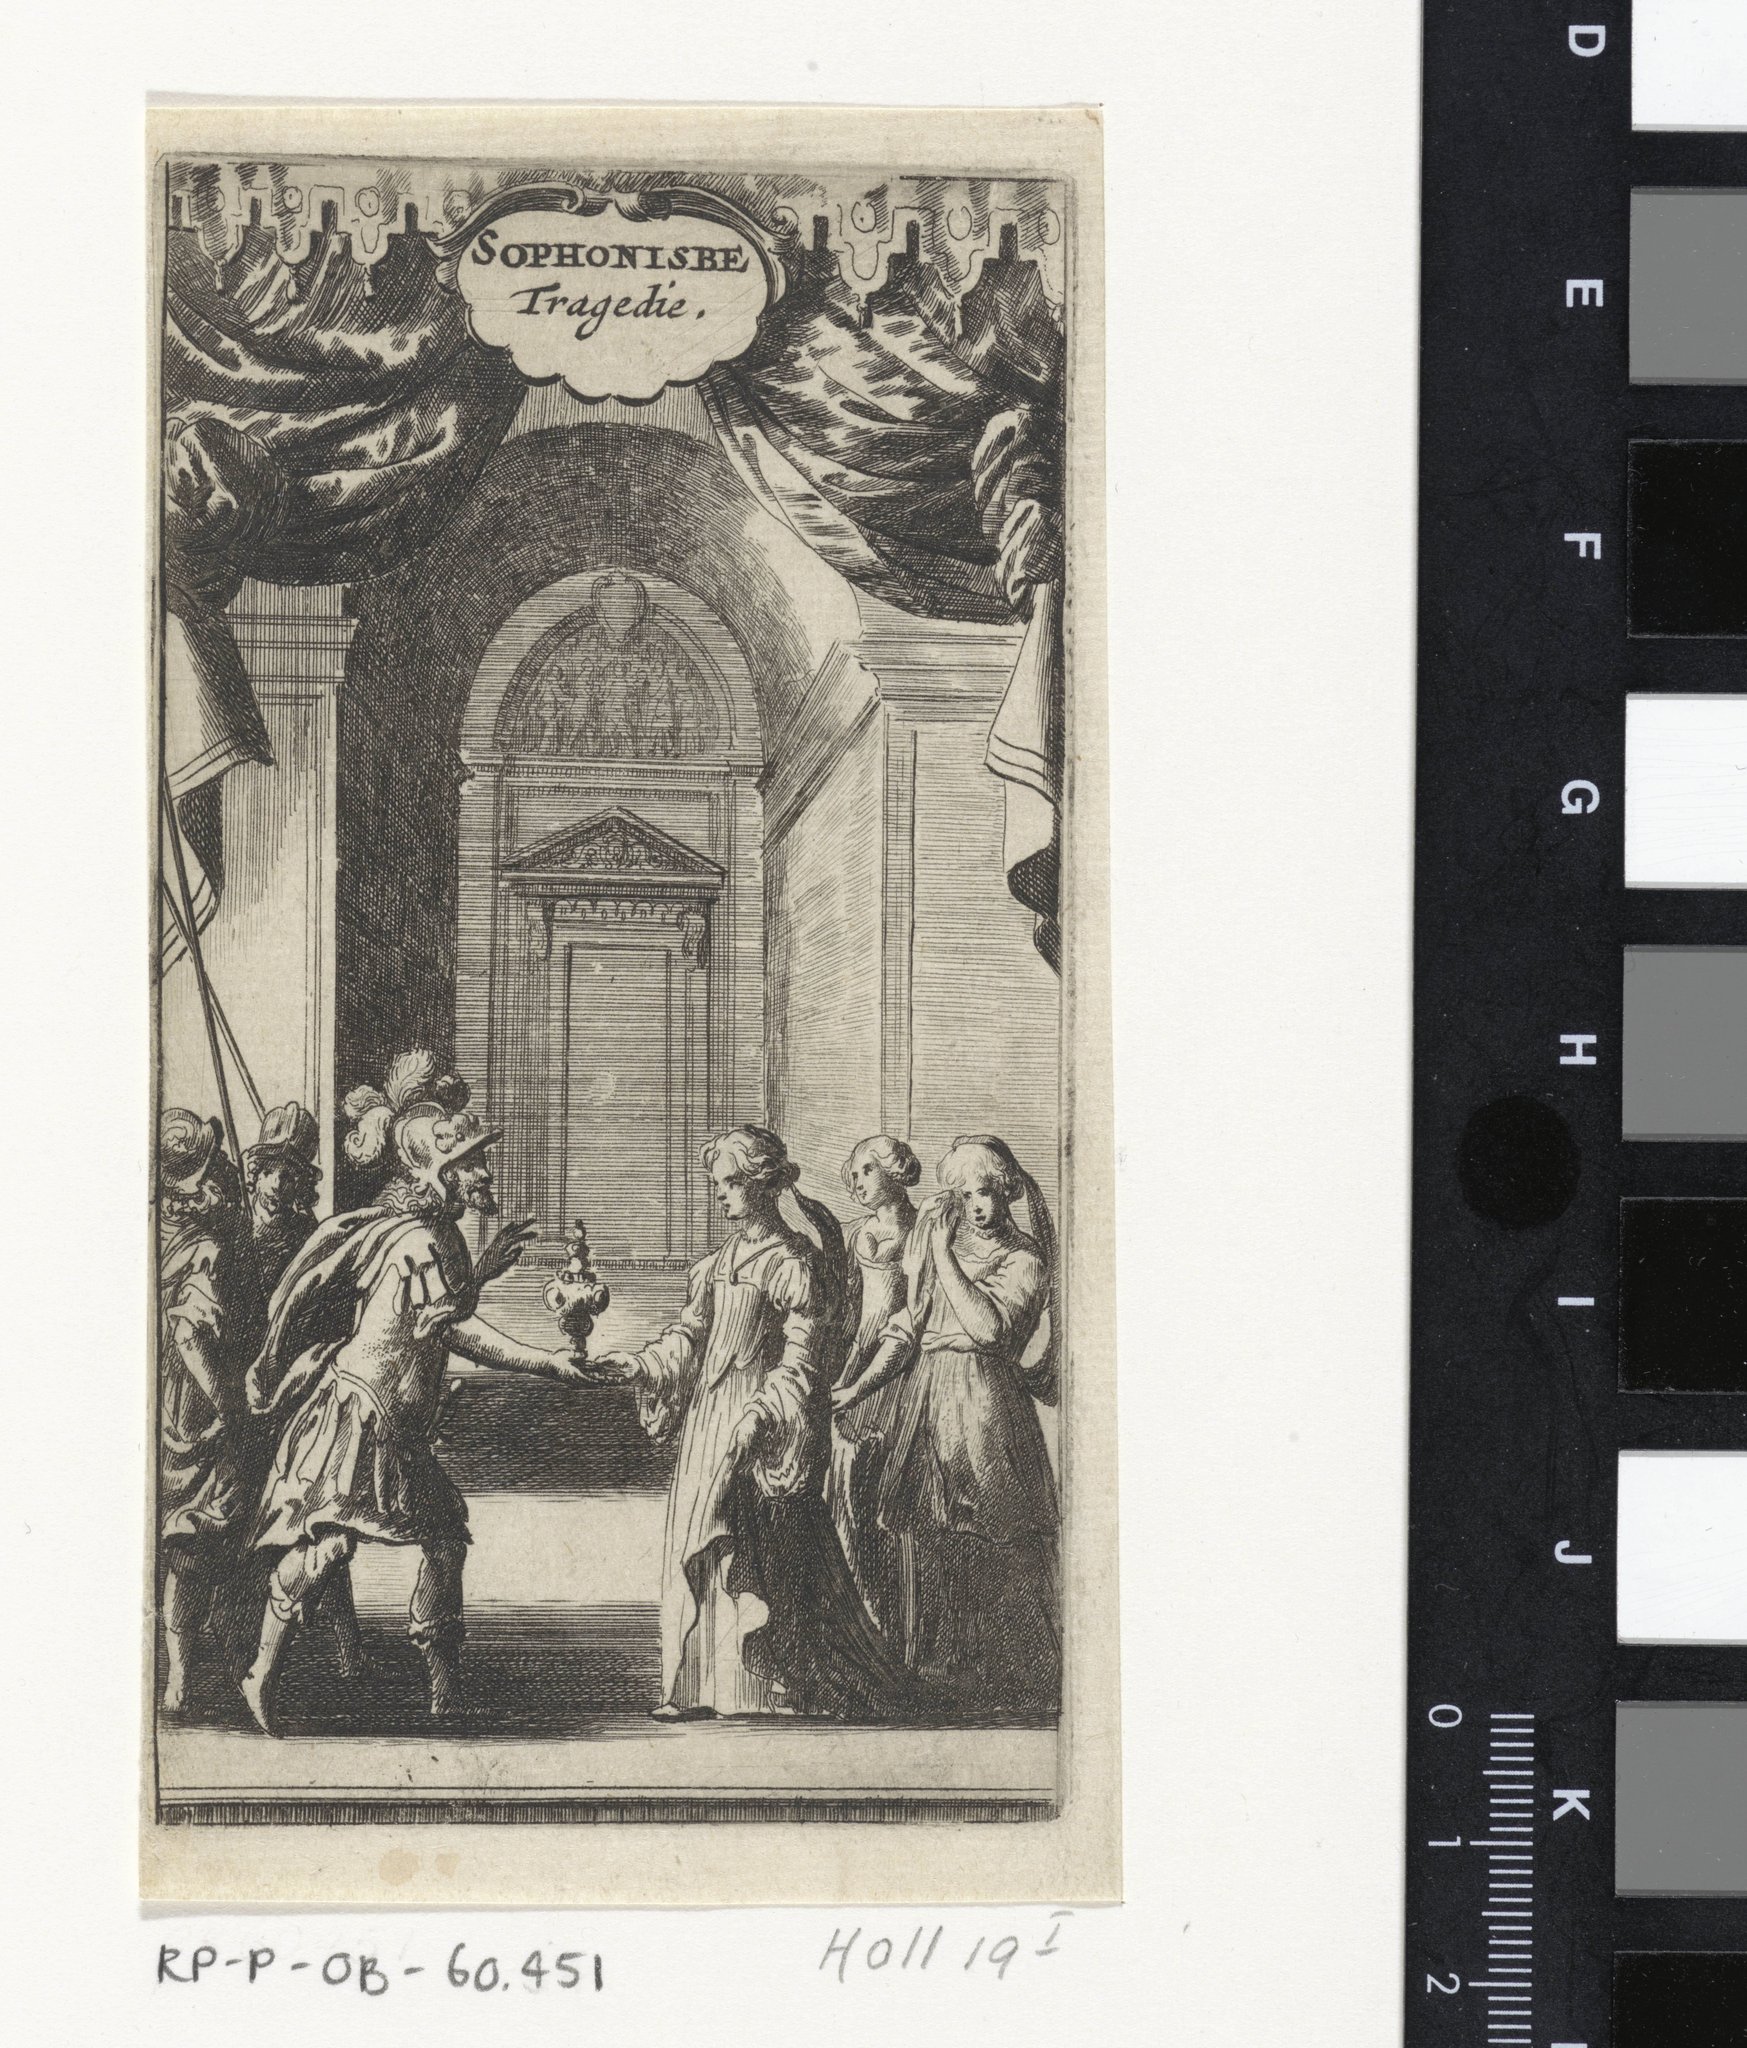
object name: print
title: Titelpagina voor: Corneille, Pierre. Sophonisbe. Tragedie, 1663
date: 1663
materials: paper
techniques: etching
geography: amsterdam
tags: theatre, theatrical performance, death of sophonisbe: she receives from a servant a cup of poison sent to her by masinissa, title-page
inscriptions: collector's mark: Lugt 2228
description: Links staat Masinissa met zijn soldaten. Hij biedt zijn vrouw Sophonisba, die tegenover hem staat, de gifbeker aan om zo te ontsnappen aan de Romeinse overheersing. Achter haar staan treurende dienaressen. Boven theatergordijnen en een cartouche met de titel.